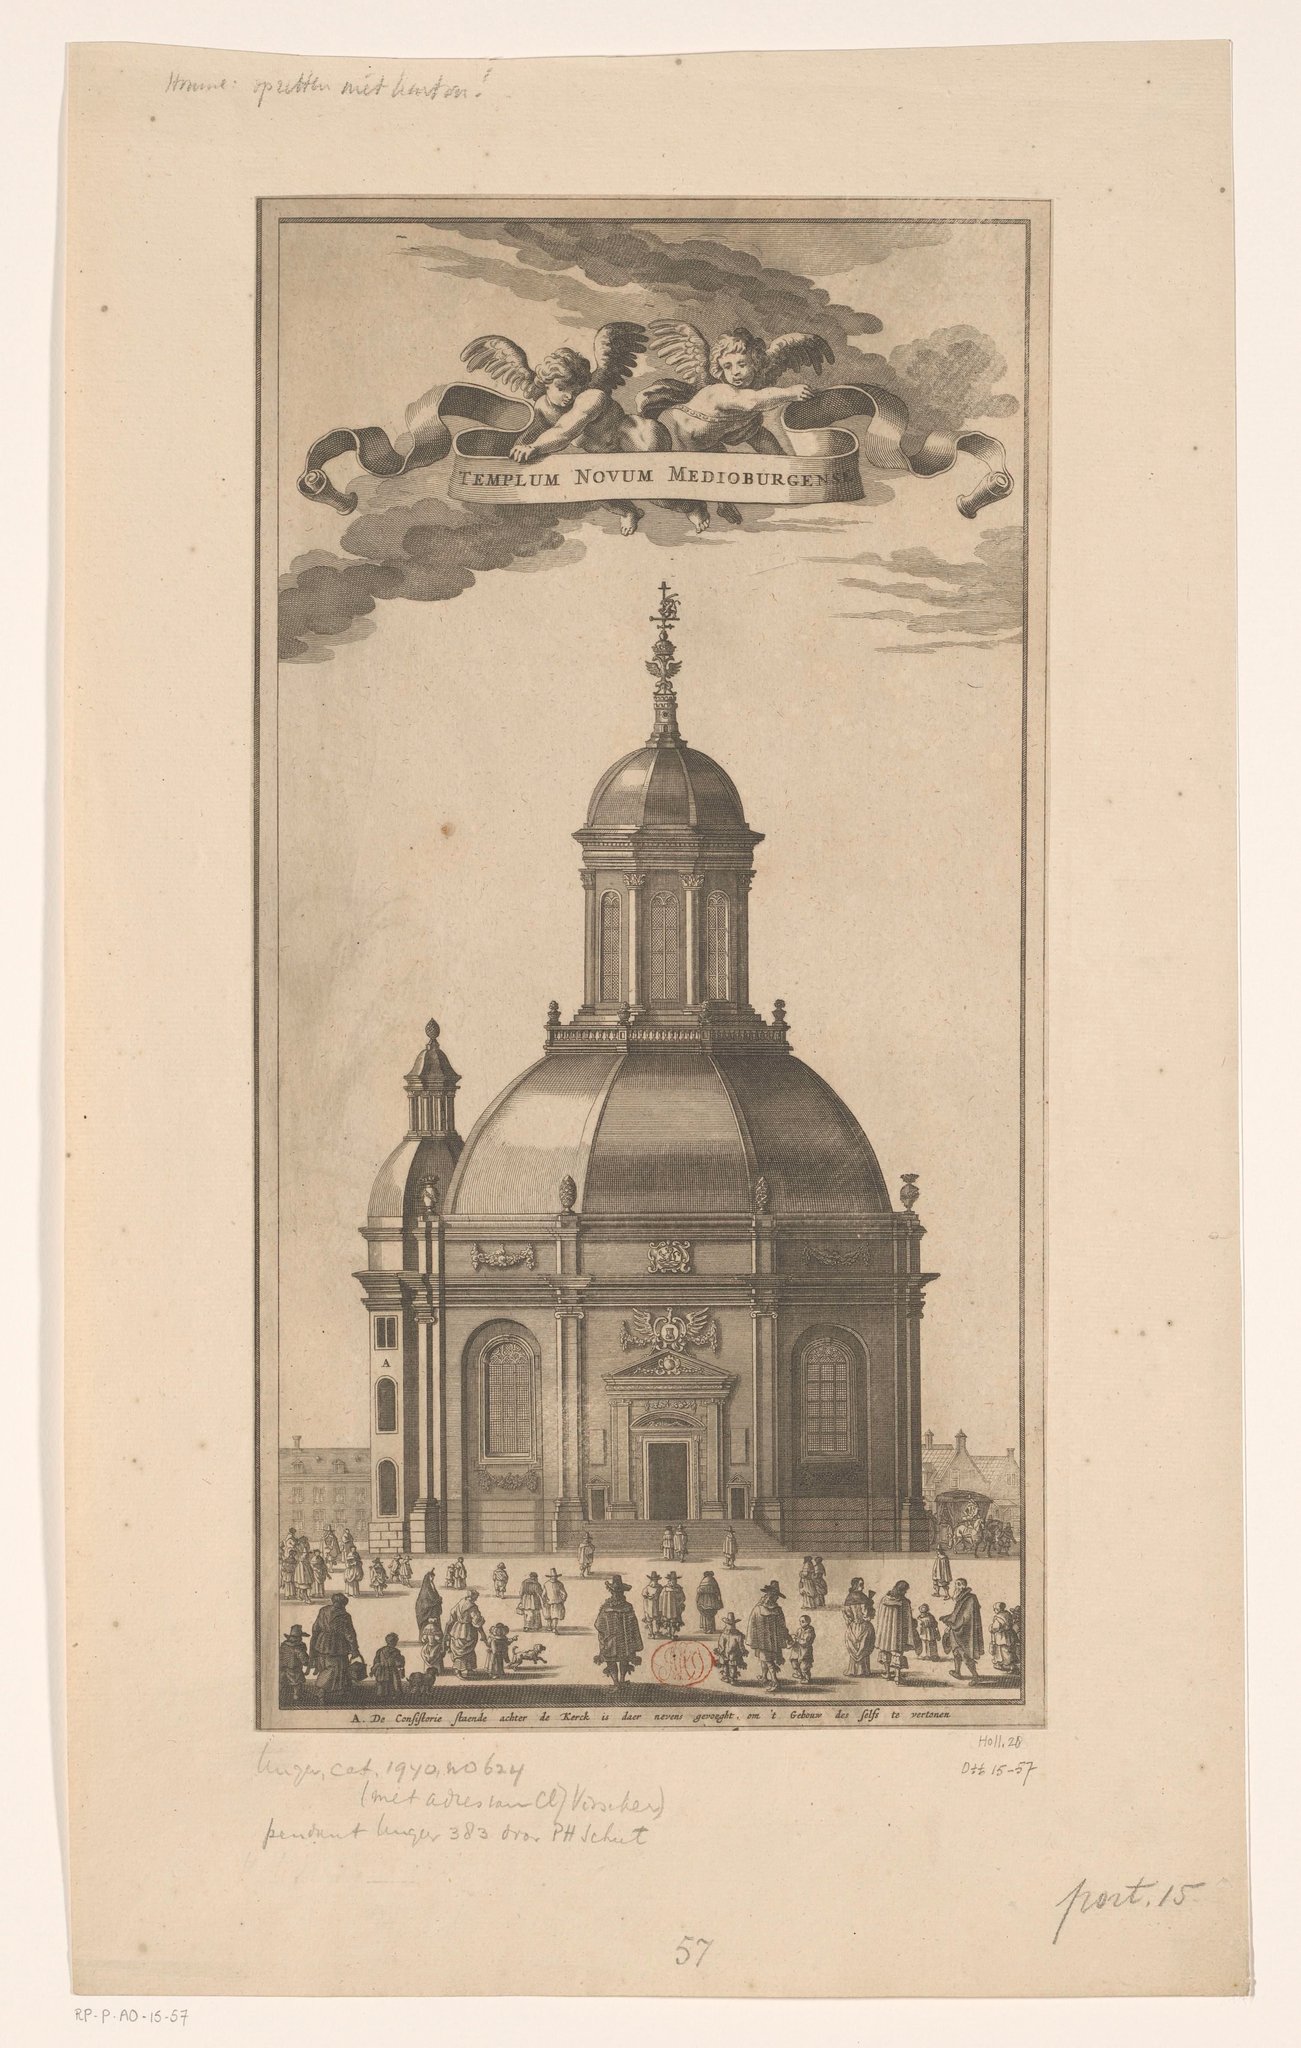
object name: print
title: Templum Novum Medioburgense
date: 1652-1679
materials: paper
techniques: engraving, etching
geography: amsterdam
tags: church (exterior)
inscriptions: collector's mark: Lugt 195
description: Gezicht op de Oostkerk te Middelburg, met voor de kerk verschillende figuren. Boven in het midden twee putti met een banderol met de titel.